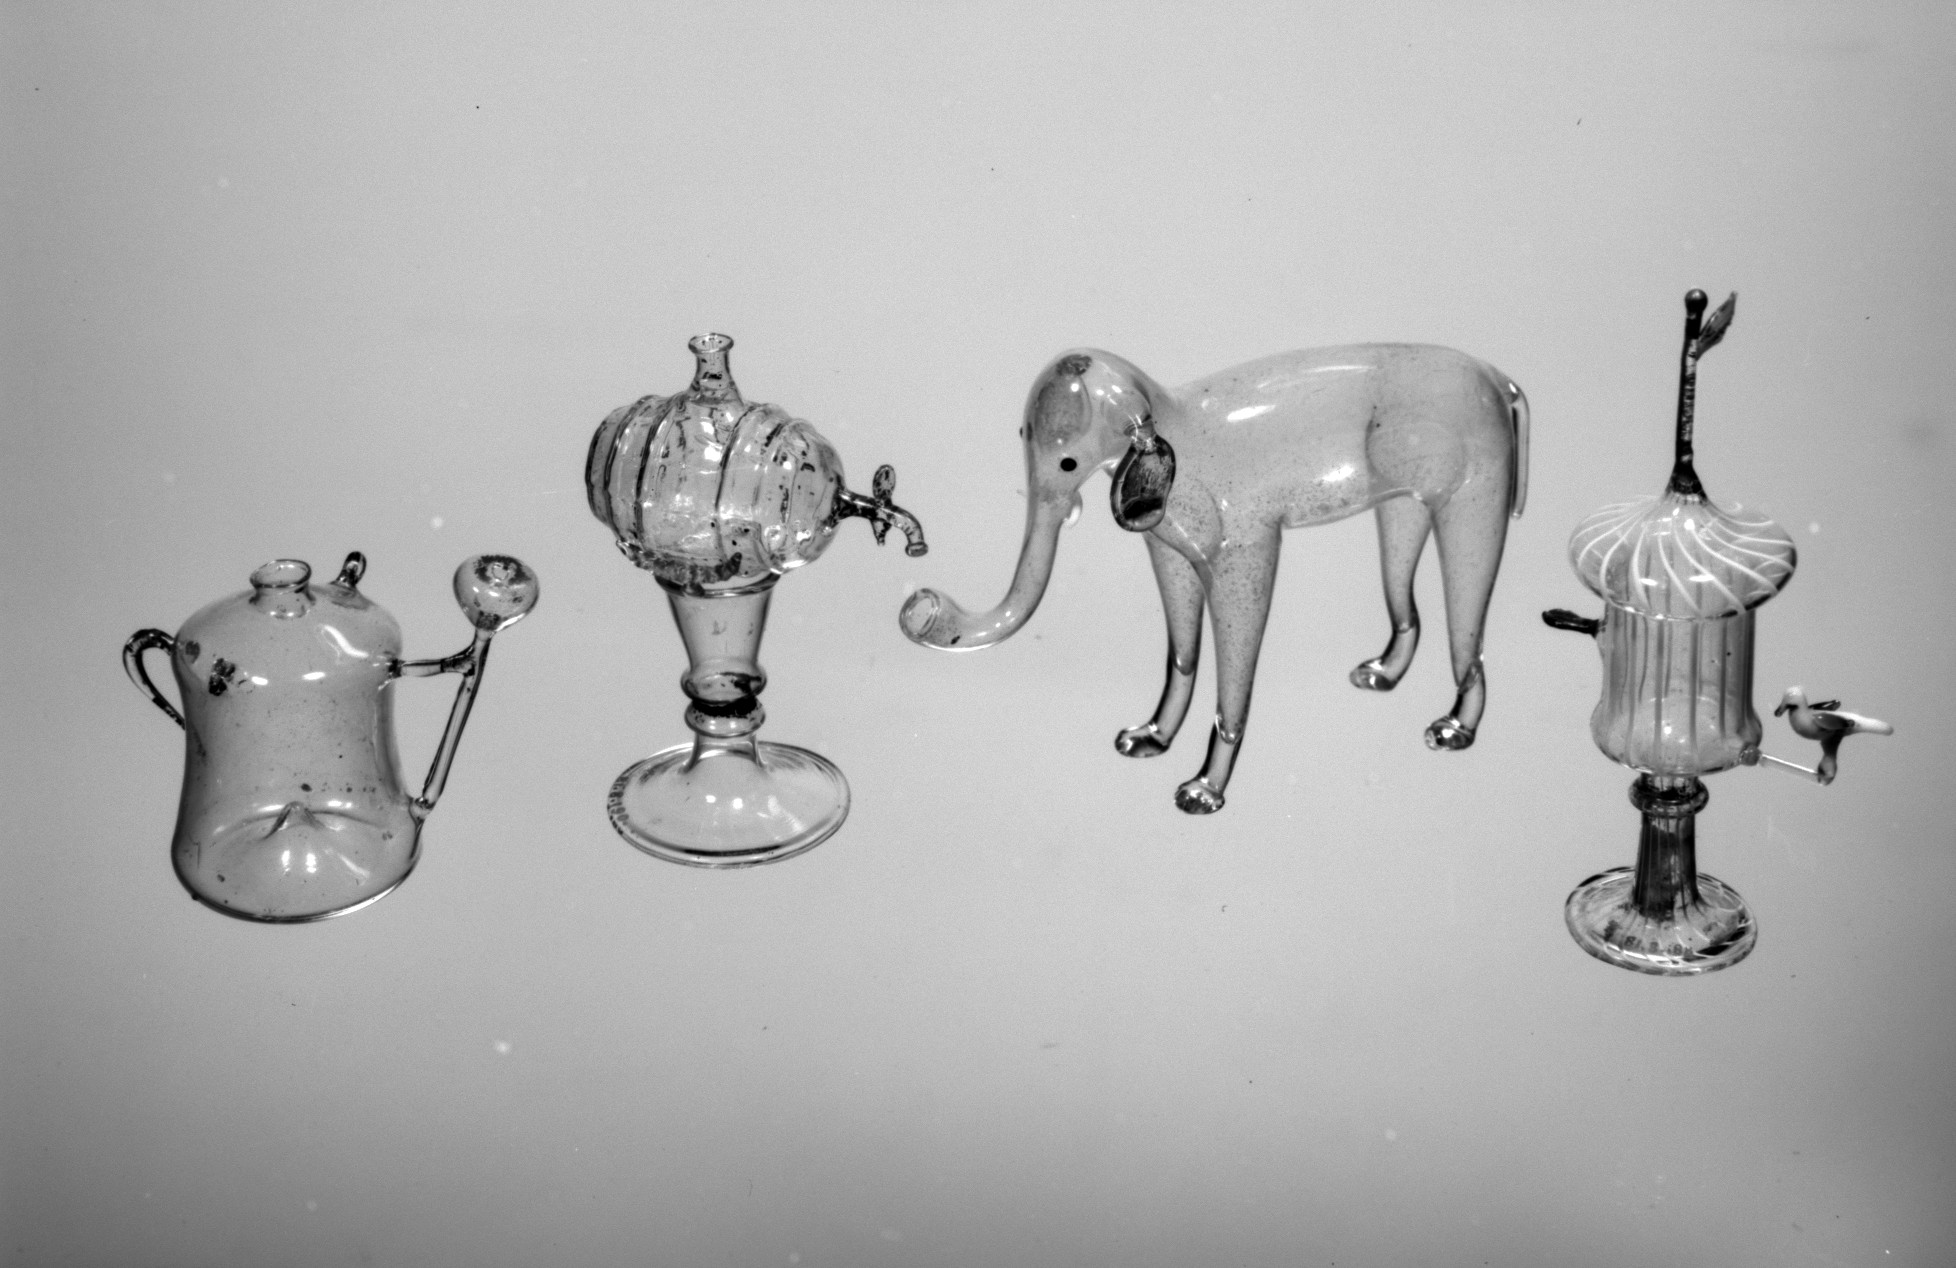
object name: barrel and stand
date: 1801-1900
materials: glass